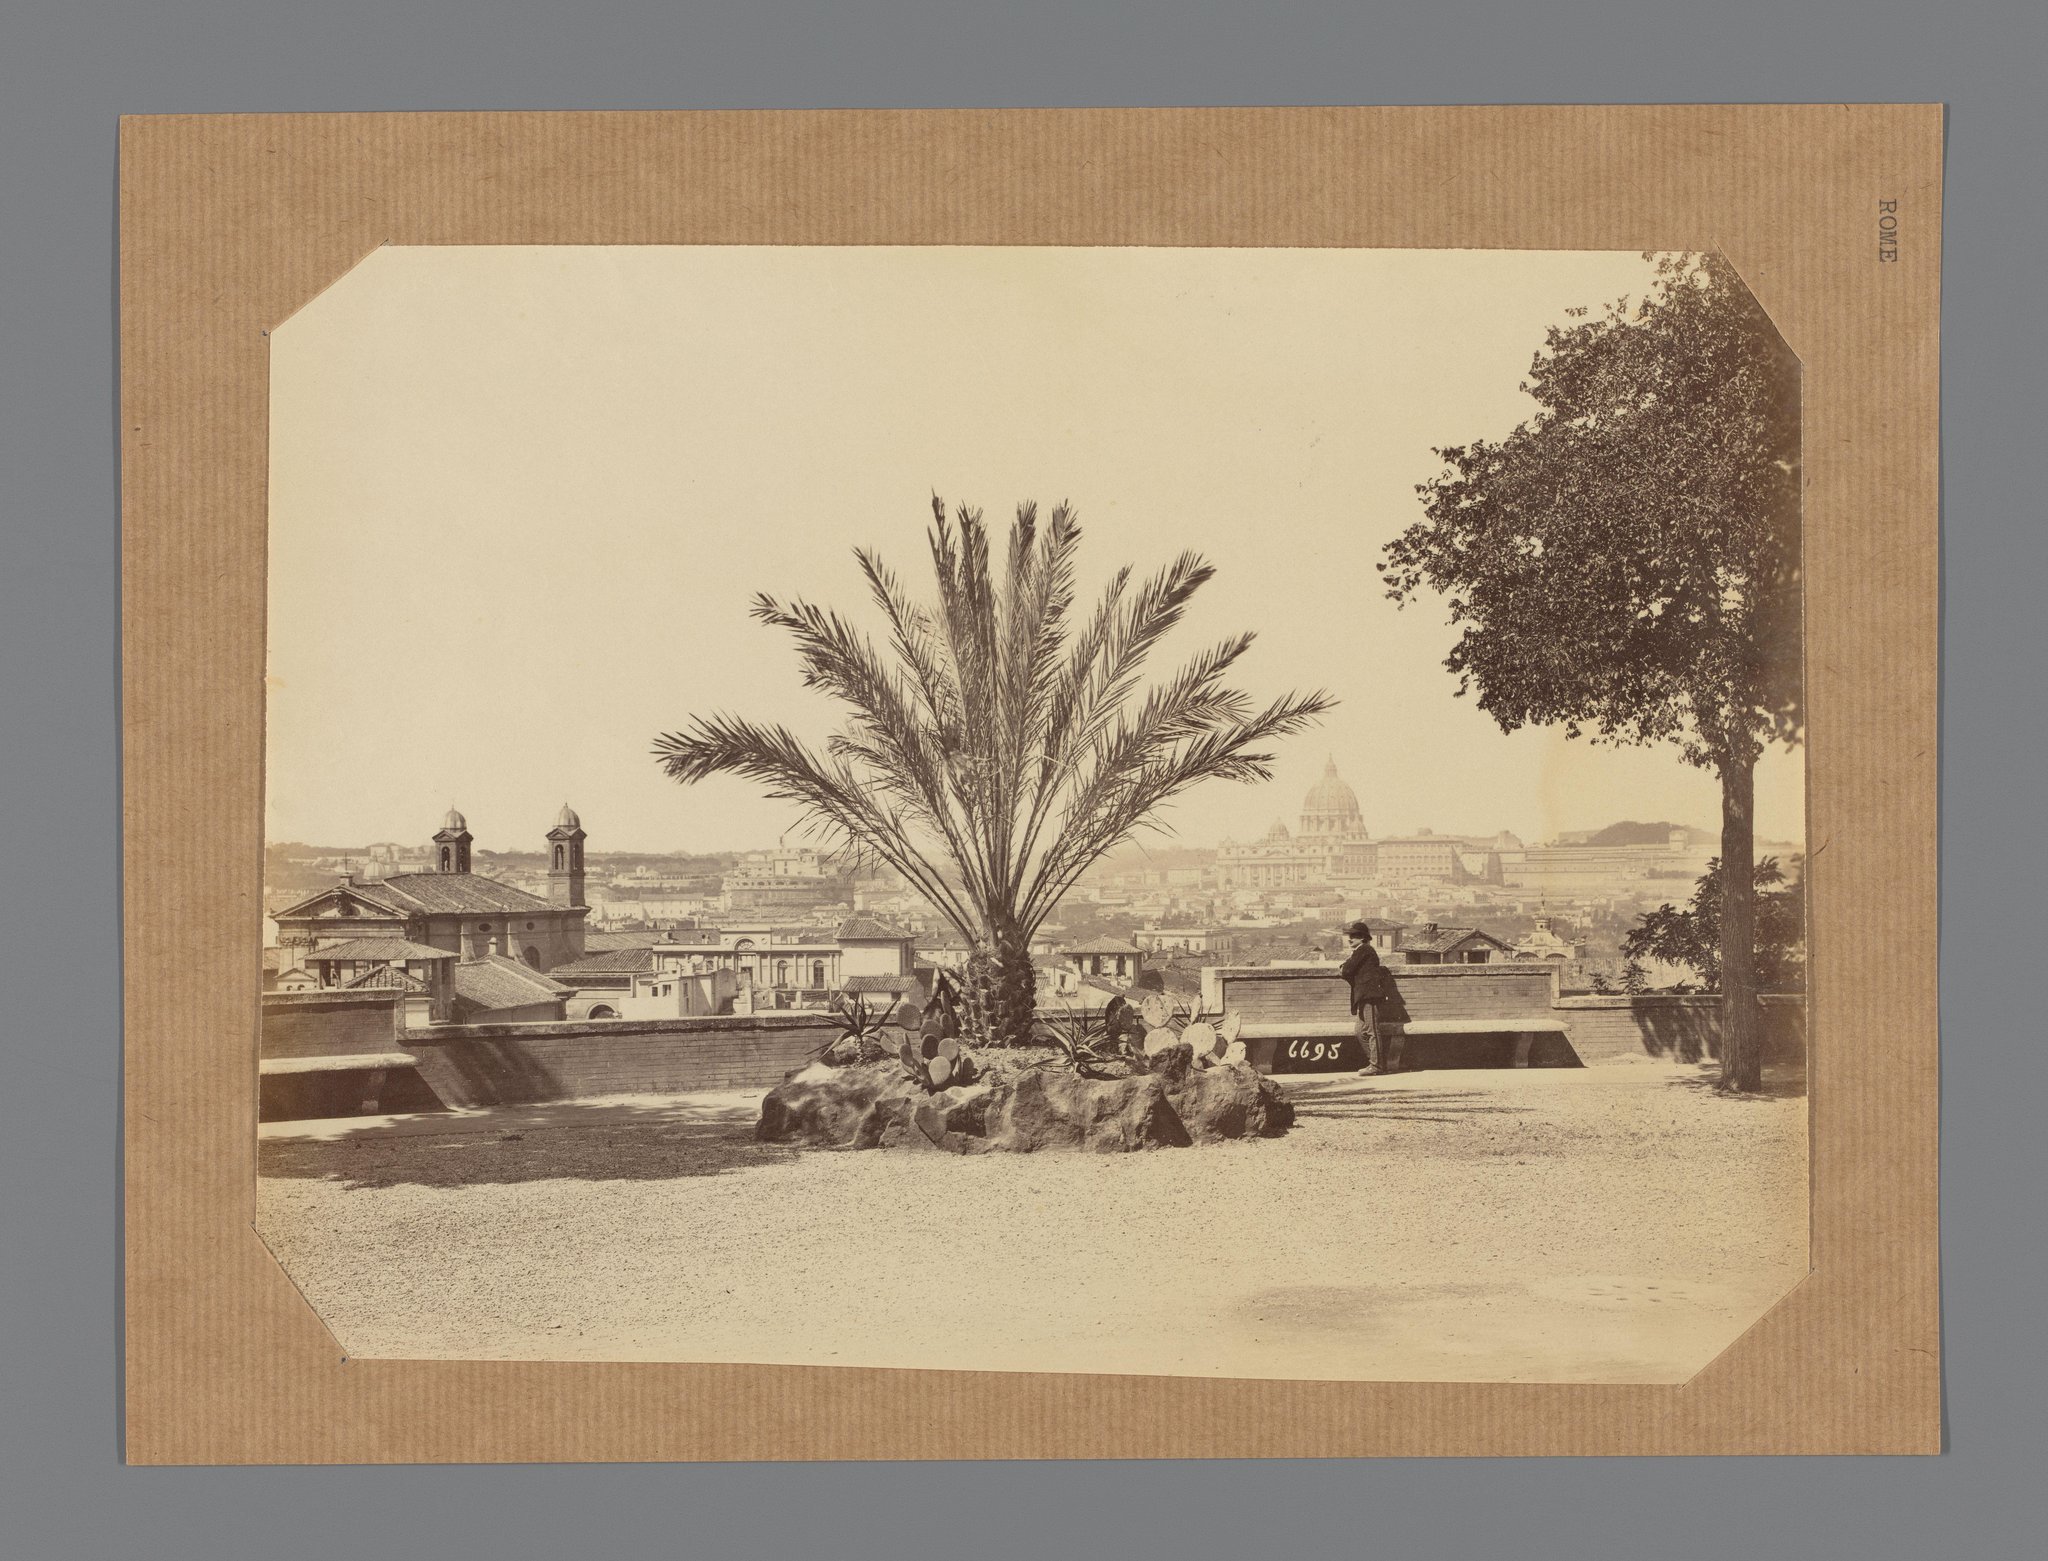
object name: photograph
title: Italië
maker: Anonymous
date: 1880-1910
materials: photographic support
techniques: albumen print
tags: italy